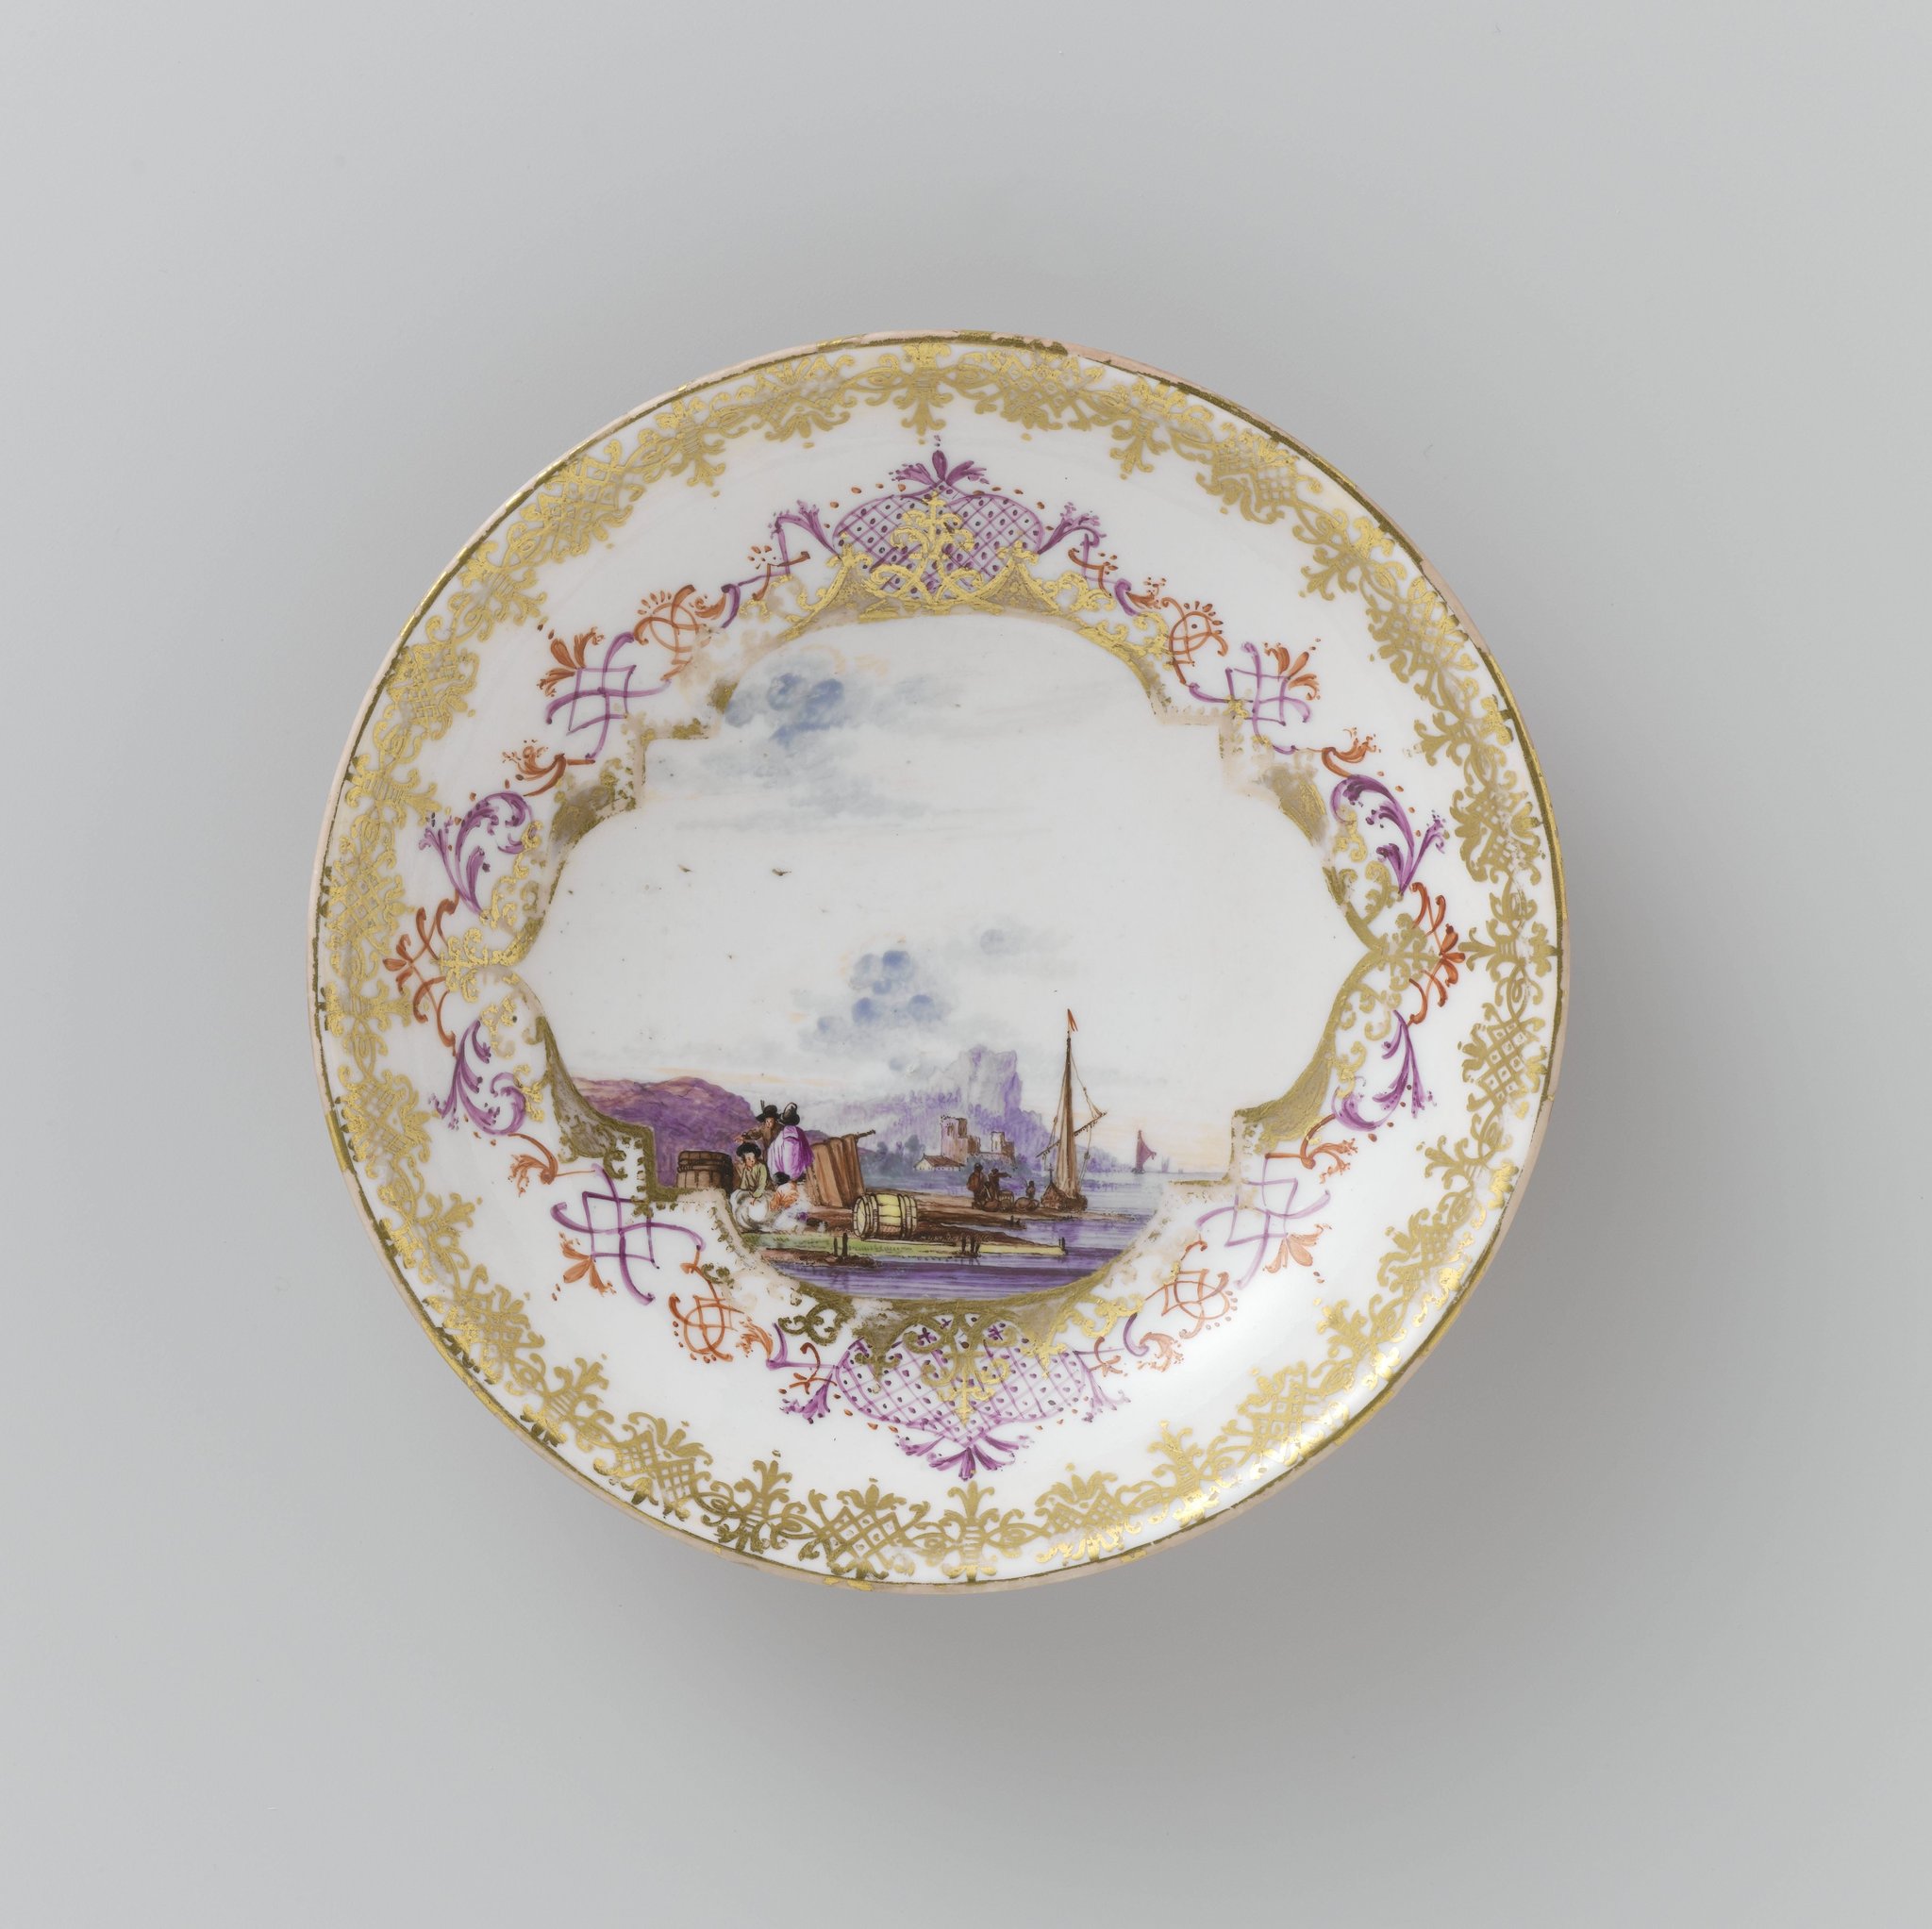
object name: eating drinking utensil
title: Schotel, veelkleurig beschilderd met een waterlandschap in een uitgespaarde vierpas in een oranjerode fond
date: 1735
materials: porcelain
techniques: painted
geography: meissen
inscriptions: factory mark, mark: ‘27’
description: Schotel van beschilderd porselein. De schotel is bedekt met een oranjerode fond, waarin accoladevormige vierpassen zijn uitgespaard met (water)landschappen met europese figuren, soms bij balen en schepen. De schotel is gemerkt en hoort bij een kop (BK-17402-H-1) en een gelijke kop en schotel (BK-17402-I-1 en BK-17402-I-2. De schotel hoort bij een thee- en chocoladeservies (BK-17402-A t/m BK-17402-X).